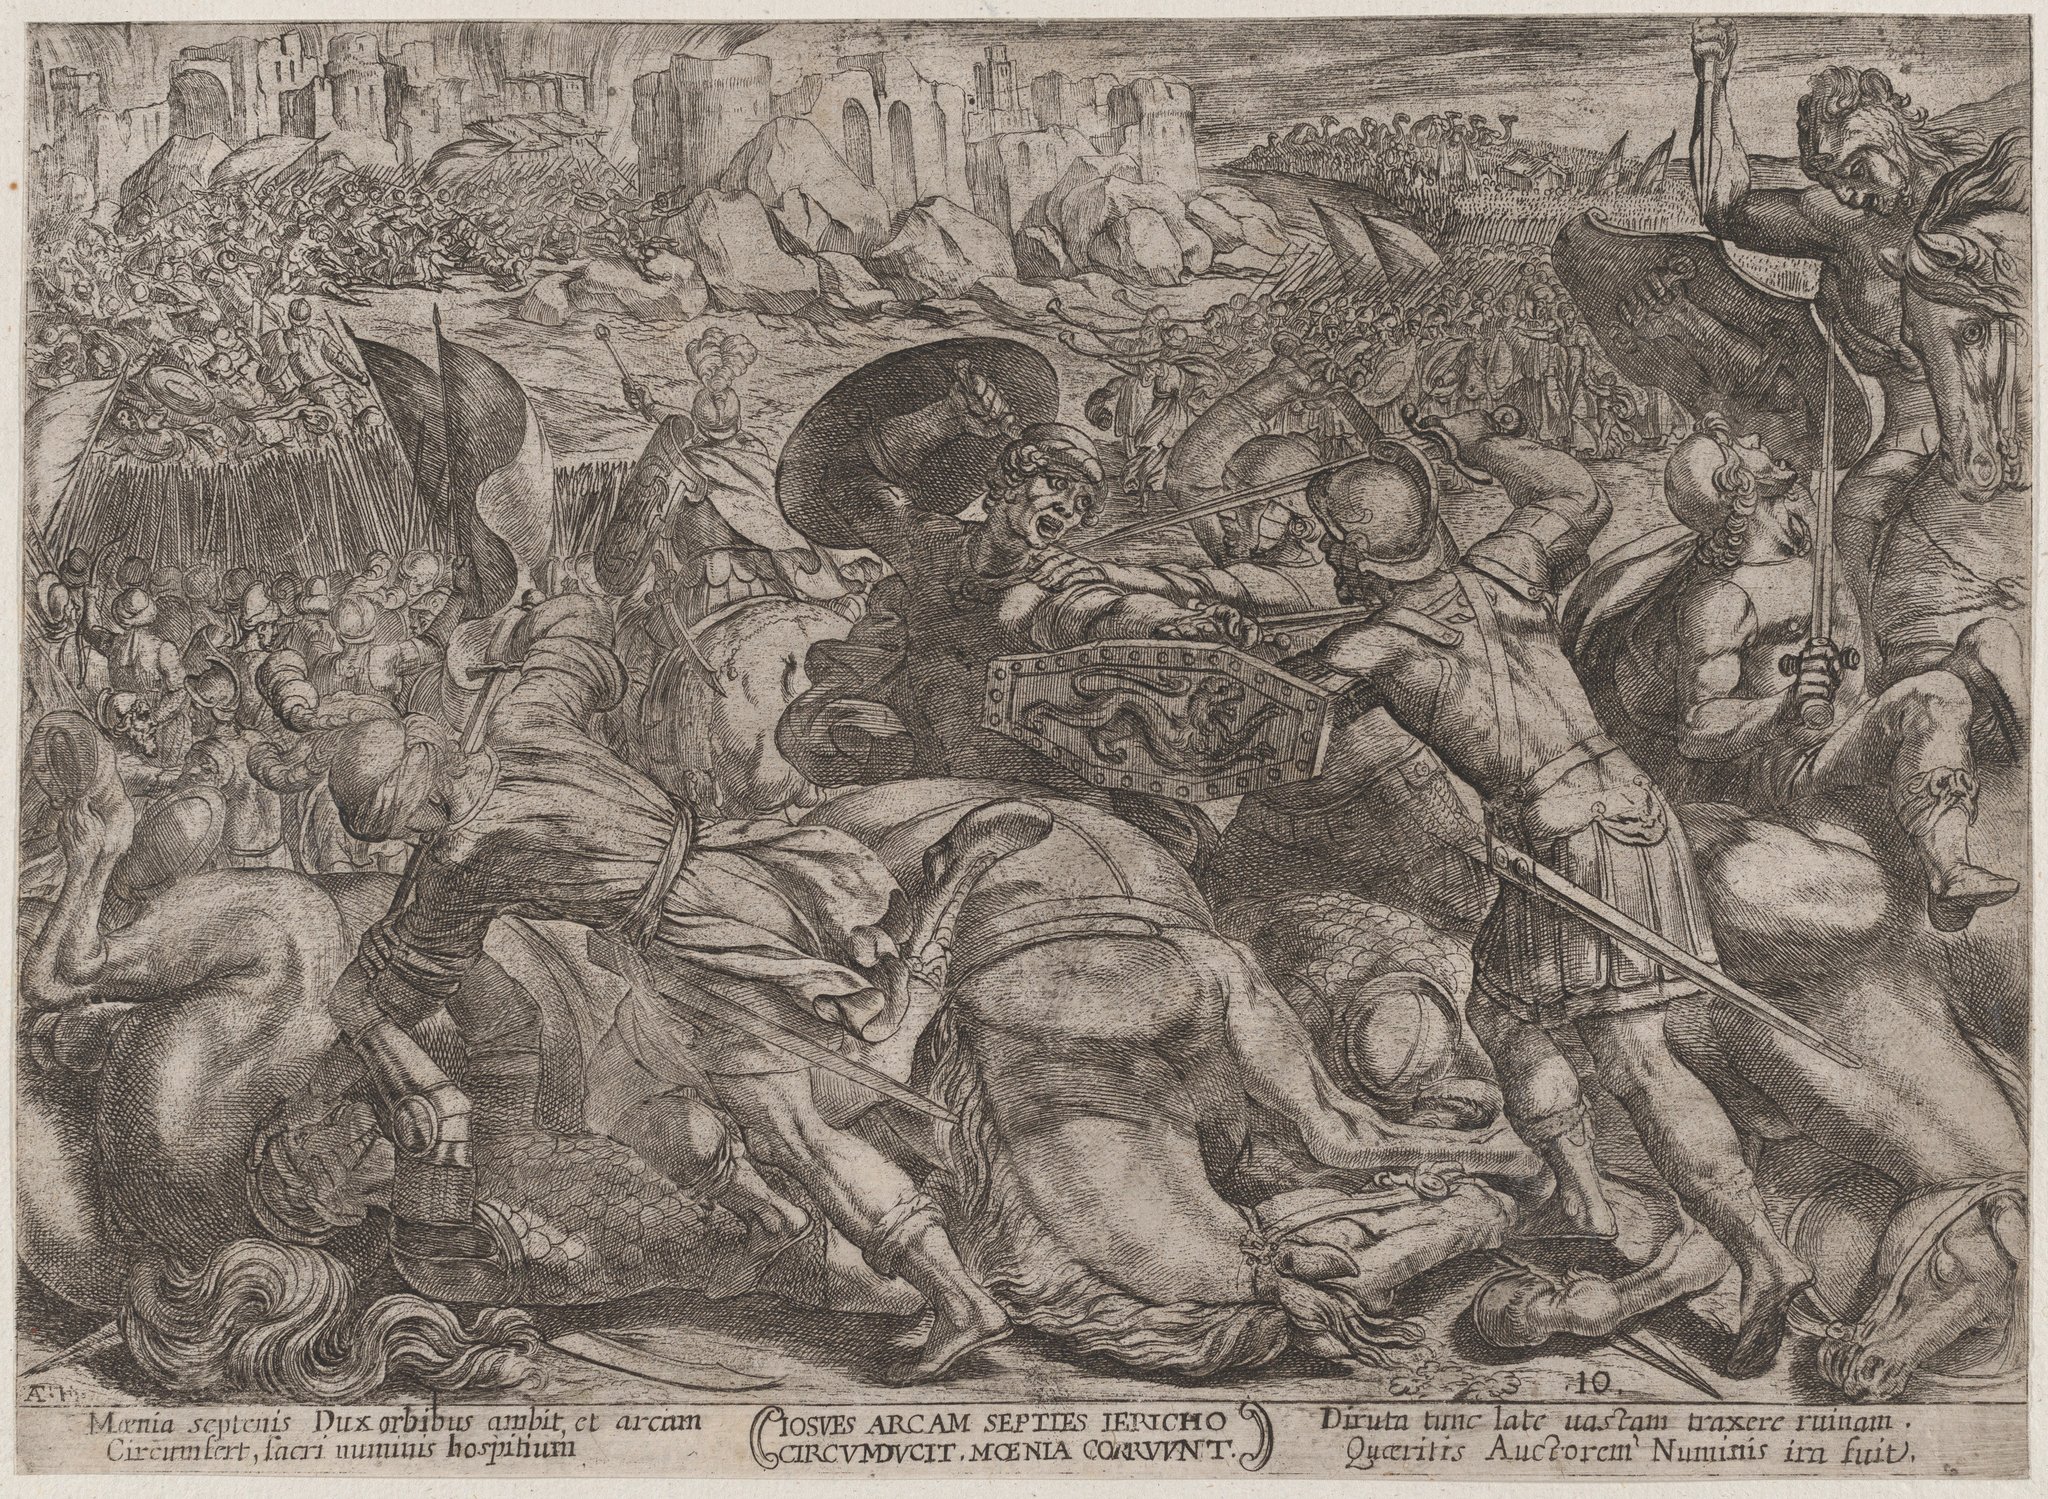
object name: print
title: Plate 10: The Fall of Jericho, from "The Battles of the Old Testament"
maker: antonio tempesta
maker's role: artist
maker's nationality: italian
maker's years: 1555-1630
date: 1590-1610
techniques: etching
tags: battles,soldiers